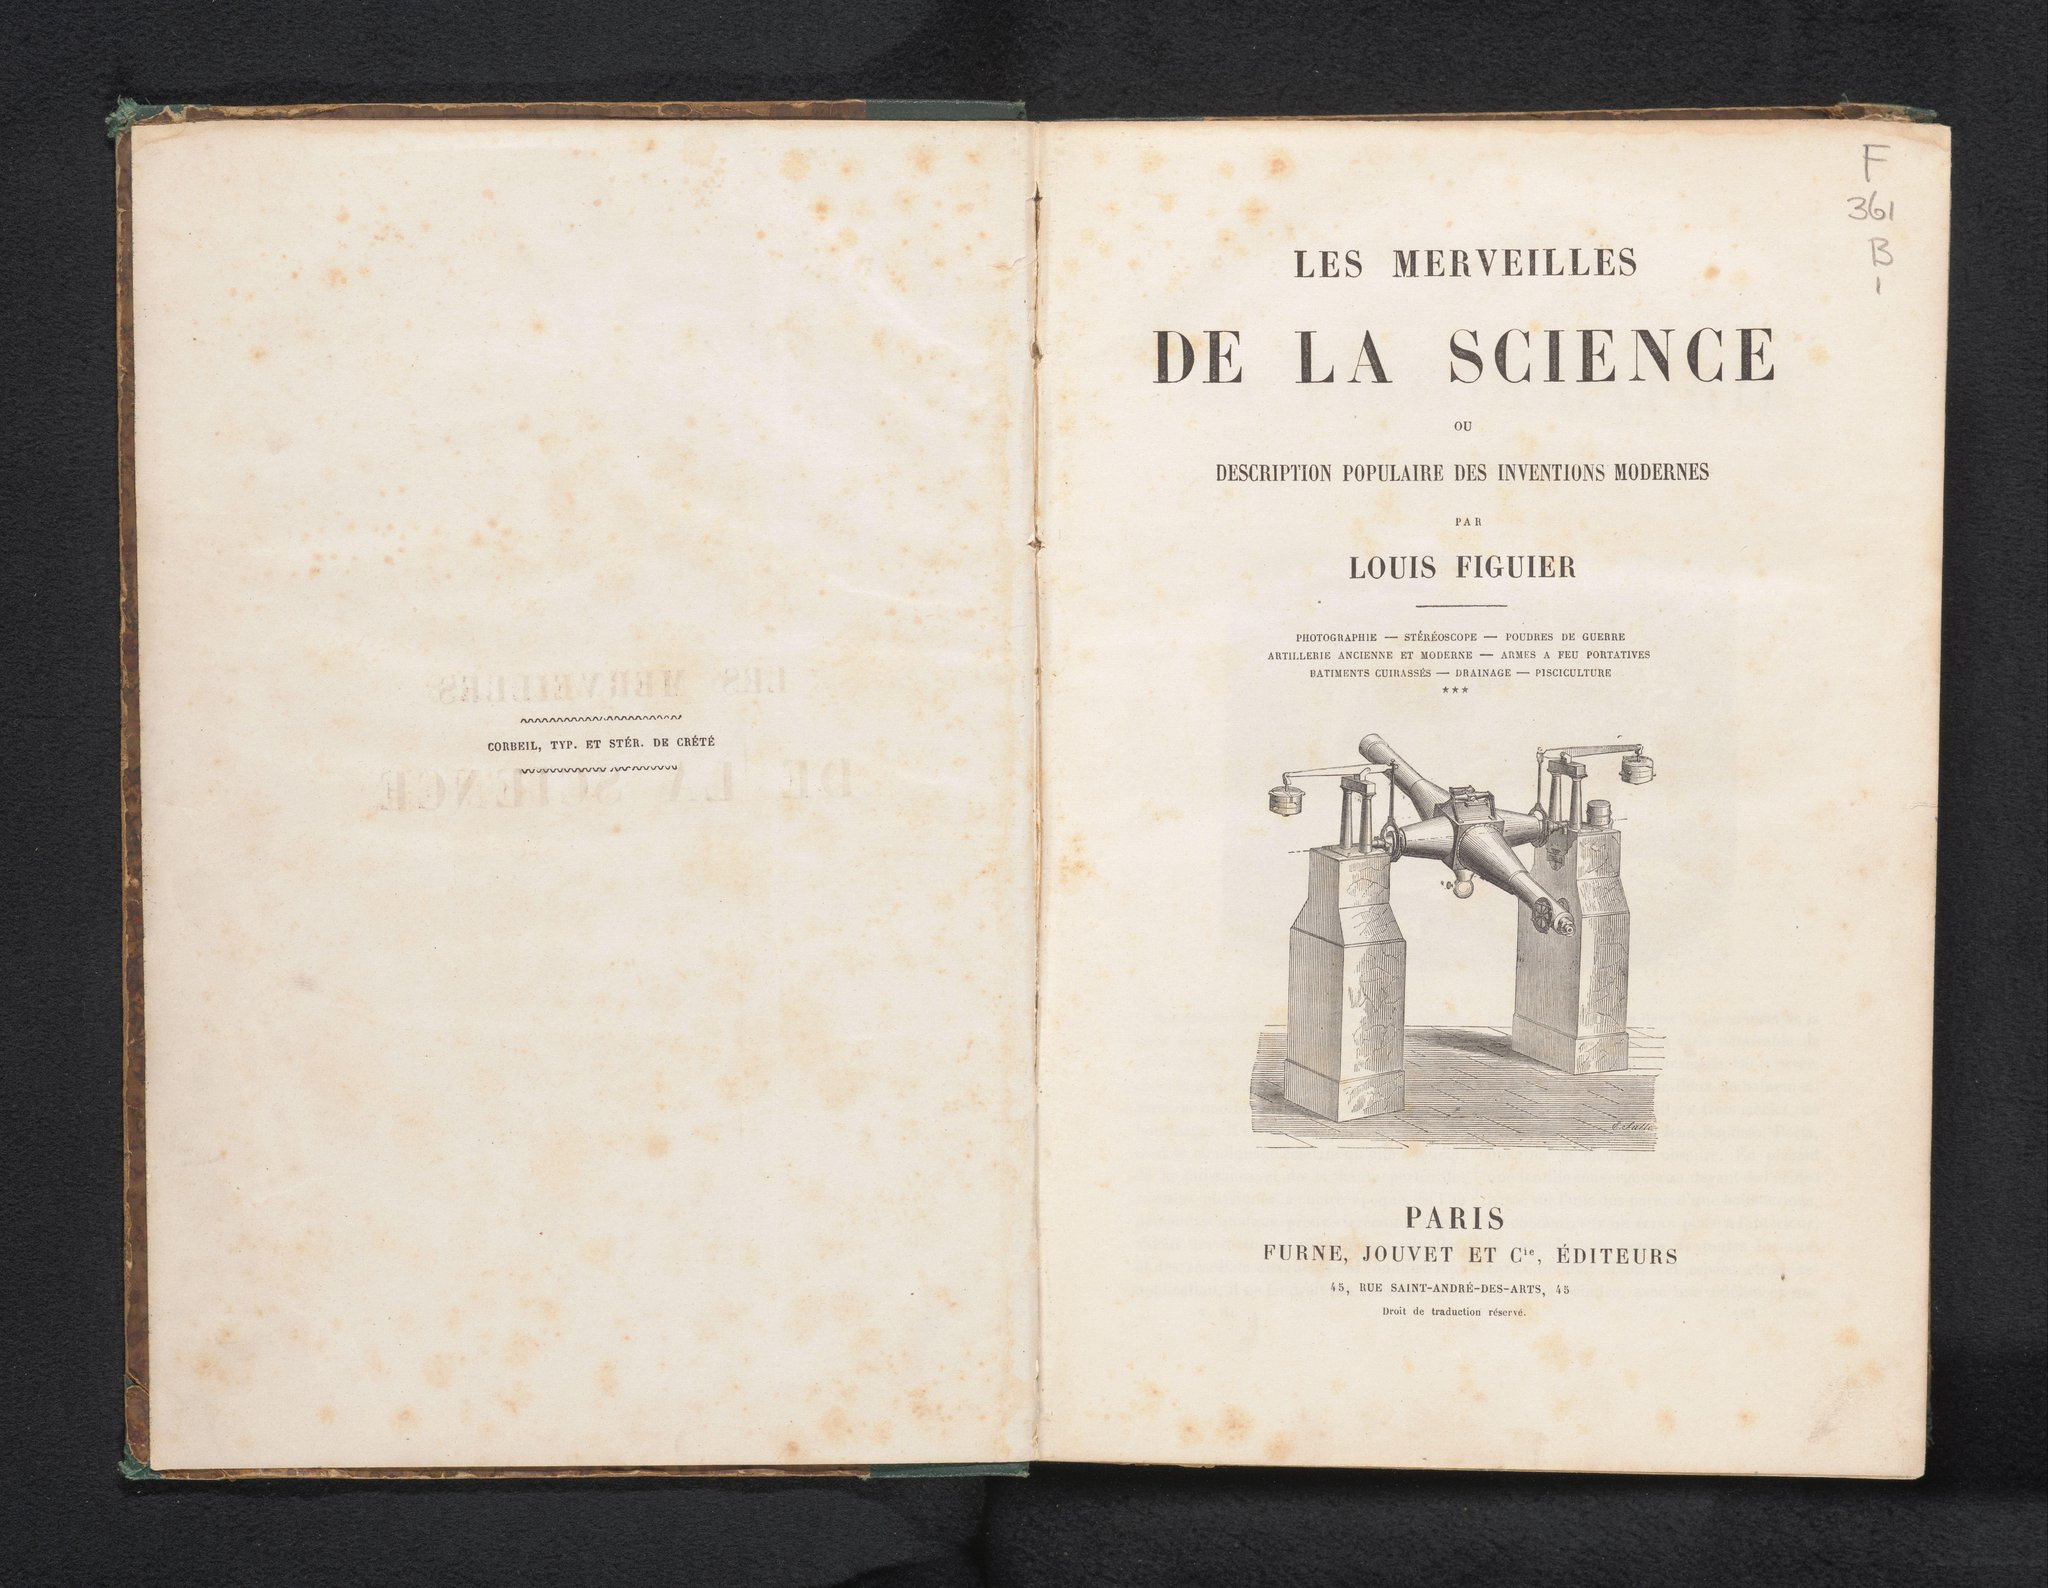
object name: book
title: Les merveilles de la science, ou, Description populaire des inventions modernes / par Louis Figuier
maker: louis figuier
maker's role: arts, journalist, schrijver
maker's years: 1819-1894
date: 1869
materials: cardboard, leather, linen, paper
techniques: printing, printing block, engraving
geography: paris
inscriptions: date: ‘OCT/ 1998’, number: ‘595’